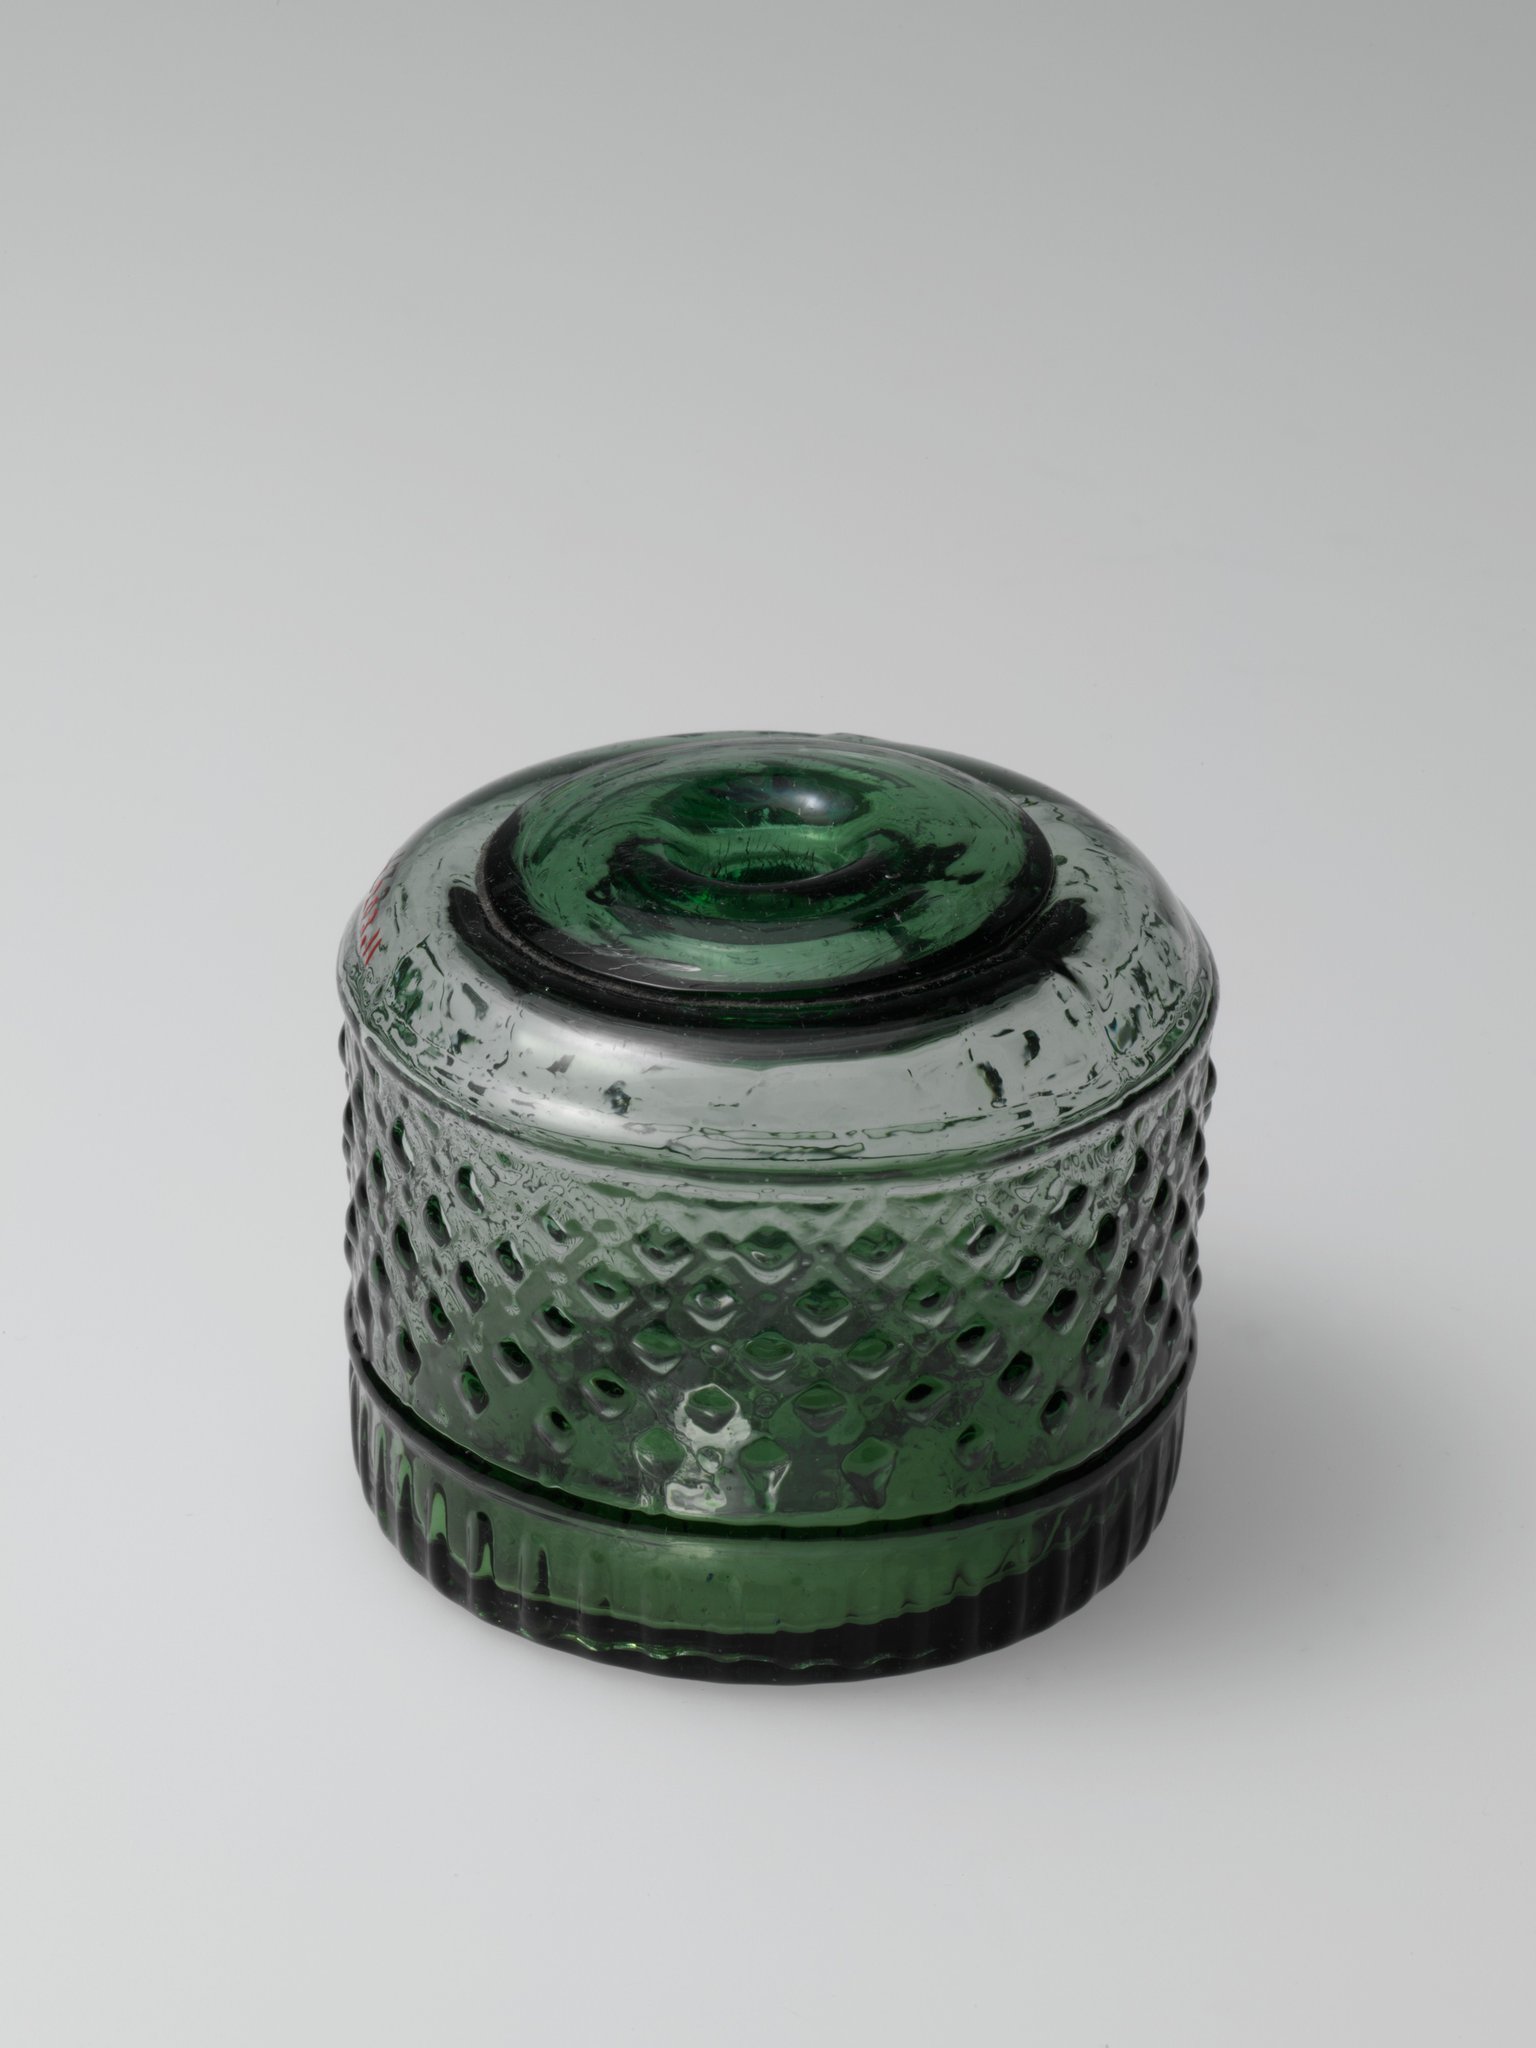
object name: inkwell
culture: american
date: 1820-1845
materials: glass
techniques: glassblowing, molding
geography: united states